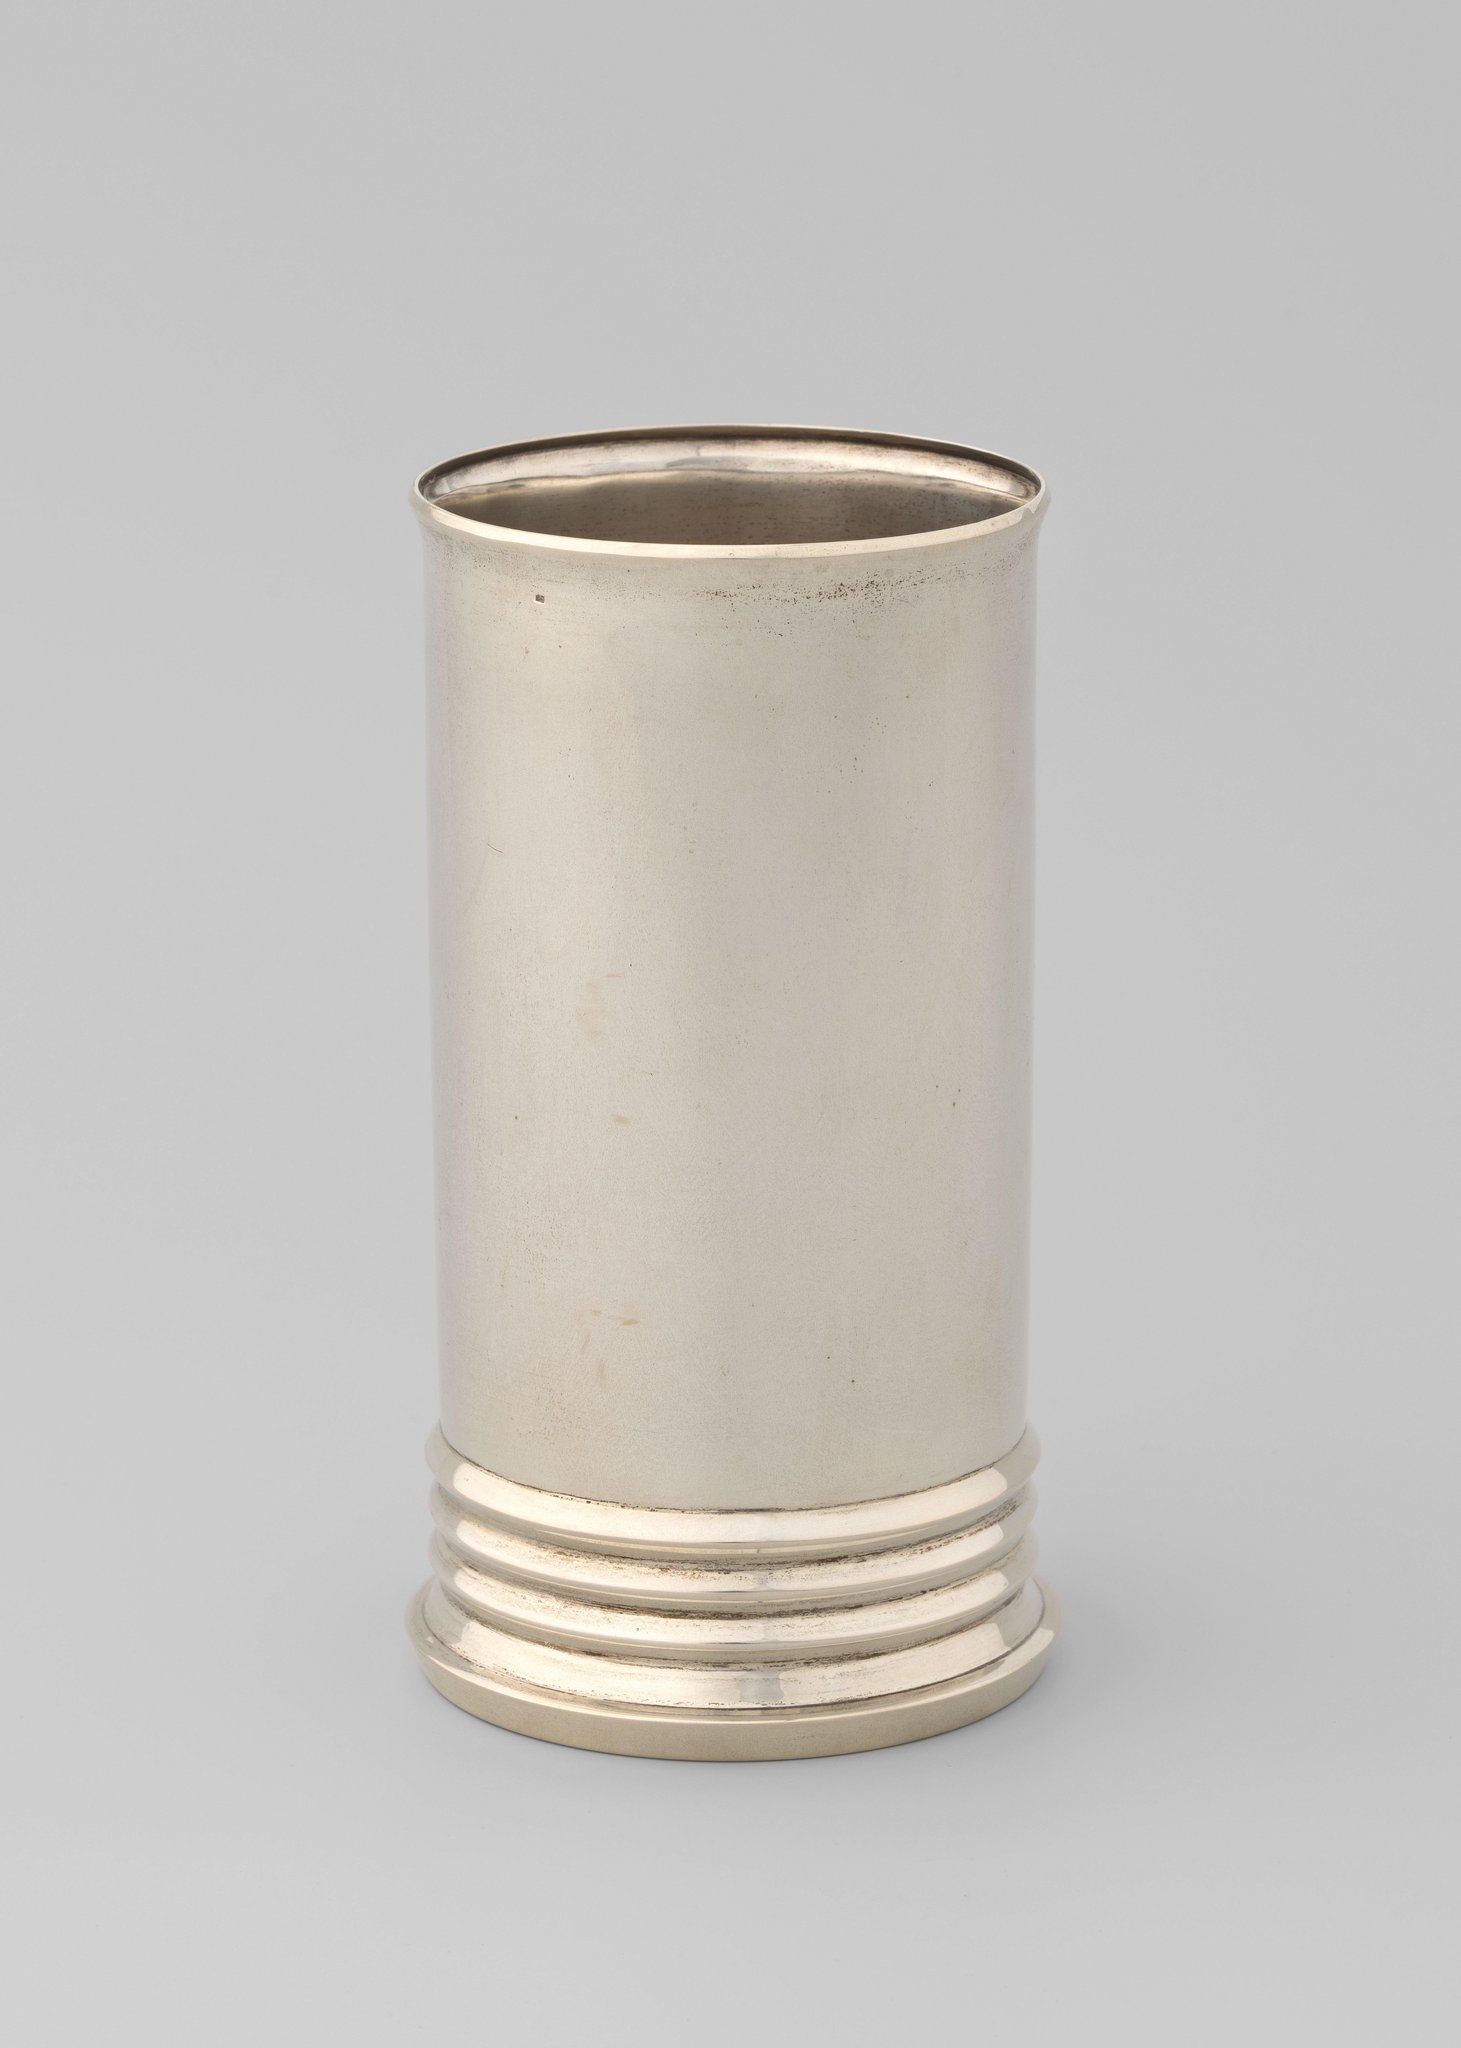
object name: cup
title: Beker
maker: carel begeer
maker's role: designer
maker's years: 1883-1956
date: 1927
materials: wood, silver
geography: voorschoten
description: Beker behorende bij een vierdelig avondmaalservies. De beker rust op een vlakke voetplaat met opstaande rand, en is opgebouwd uit één cilinder. De mondrand is aangeduid met een gebold gedeelte.